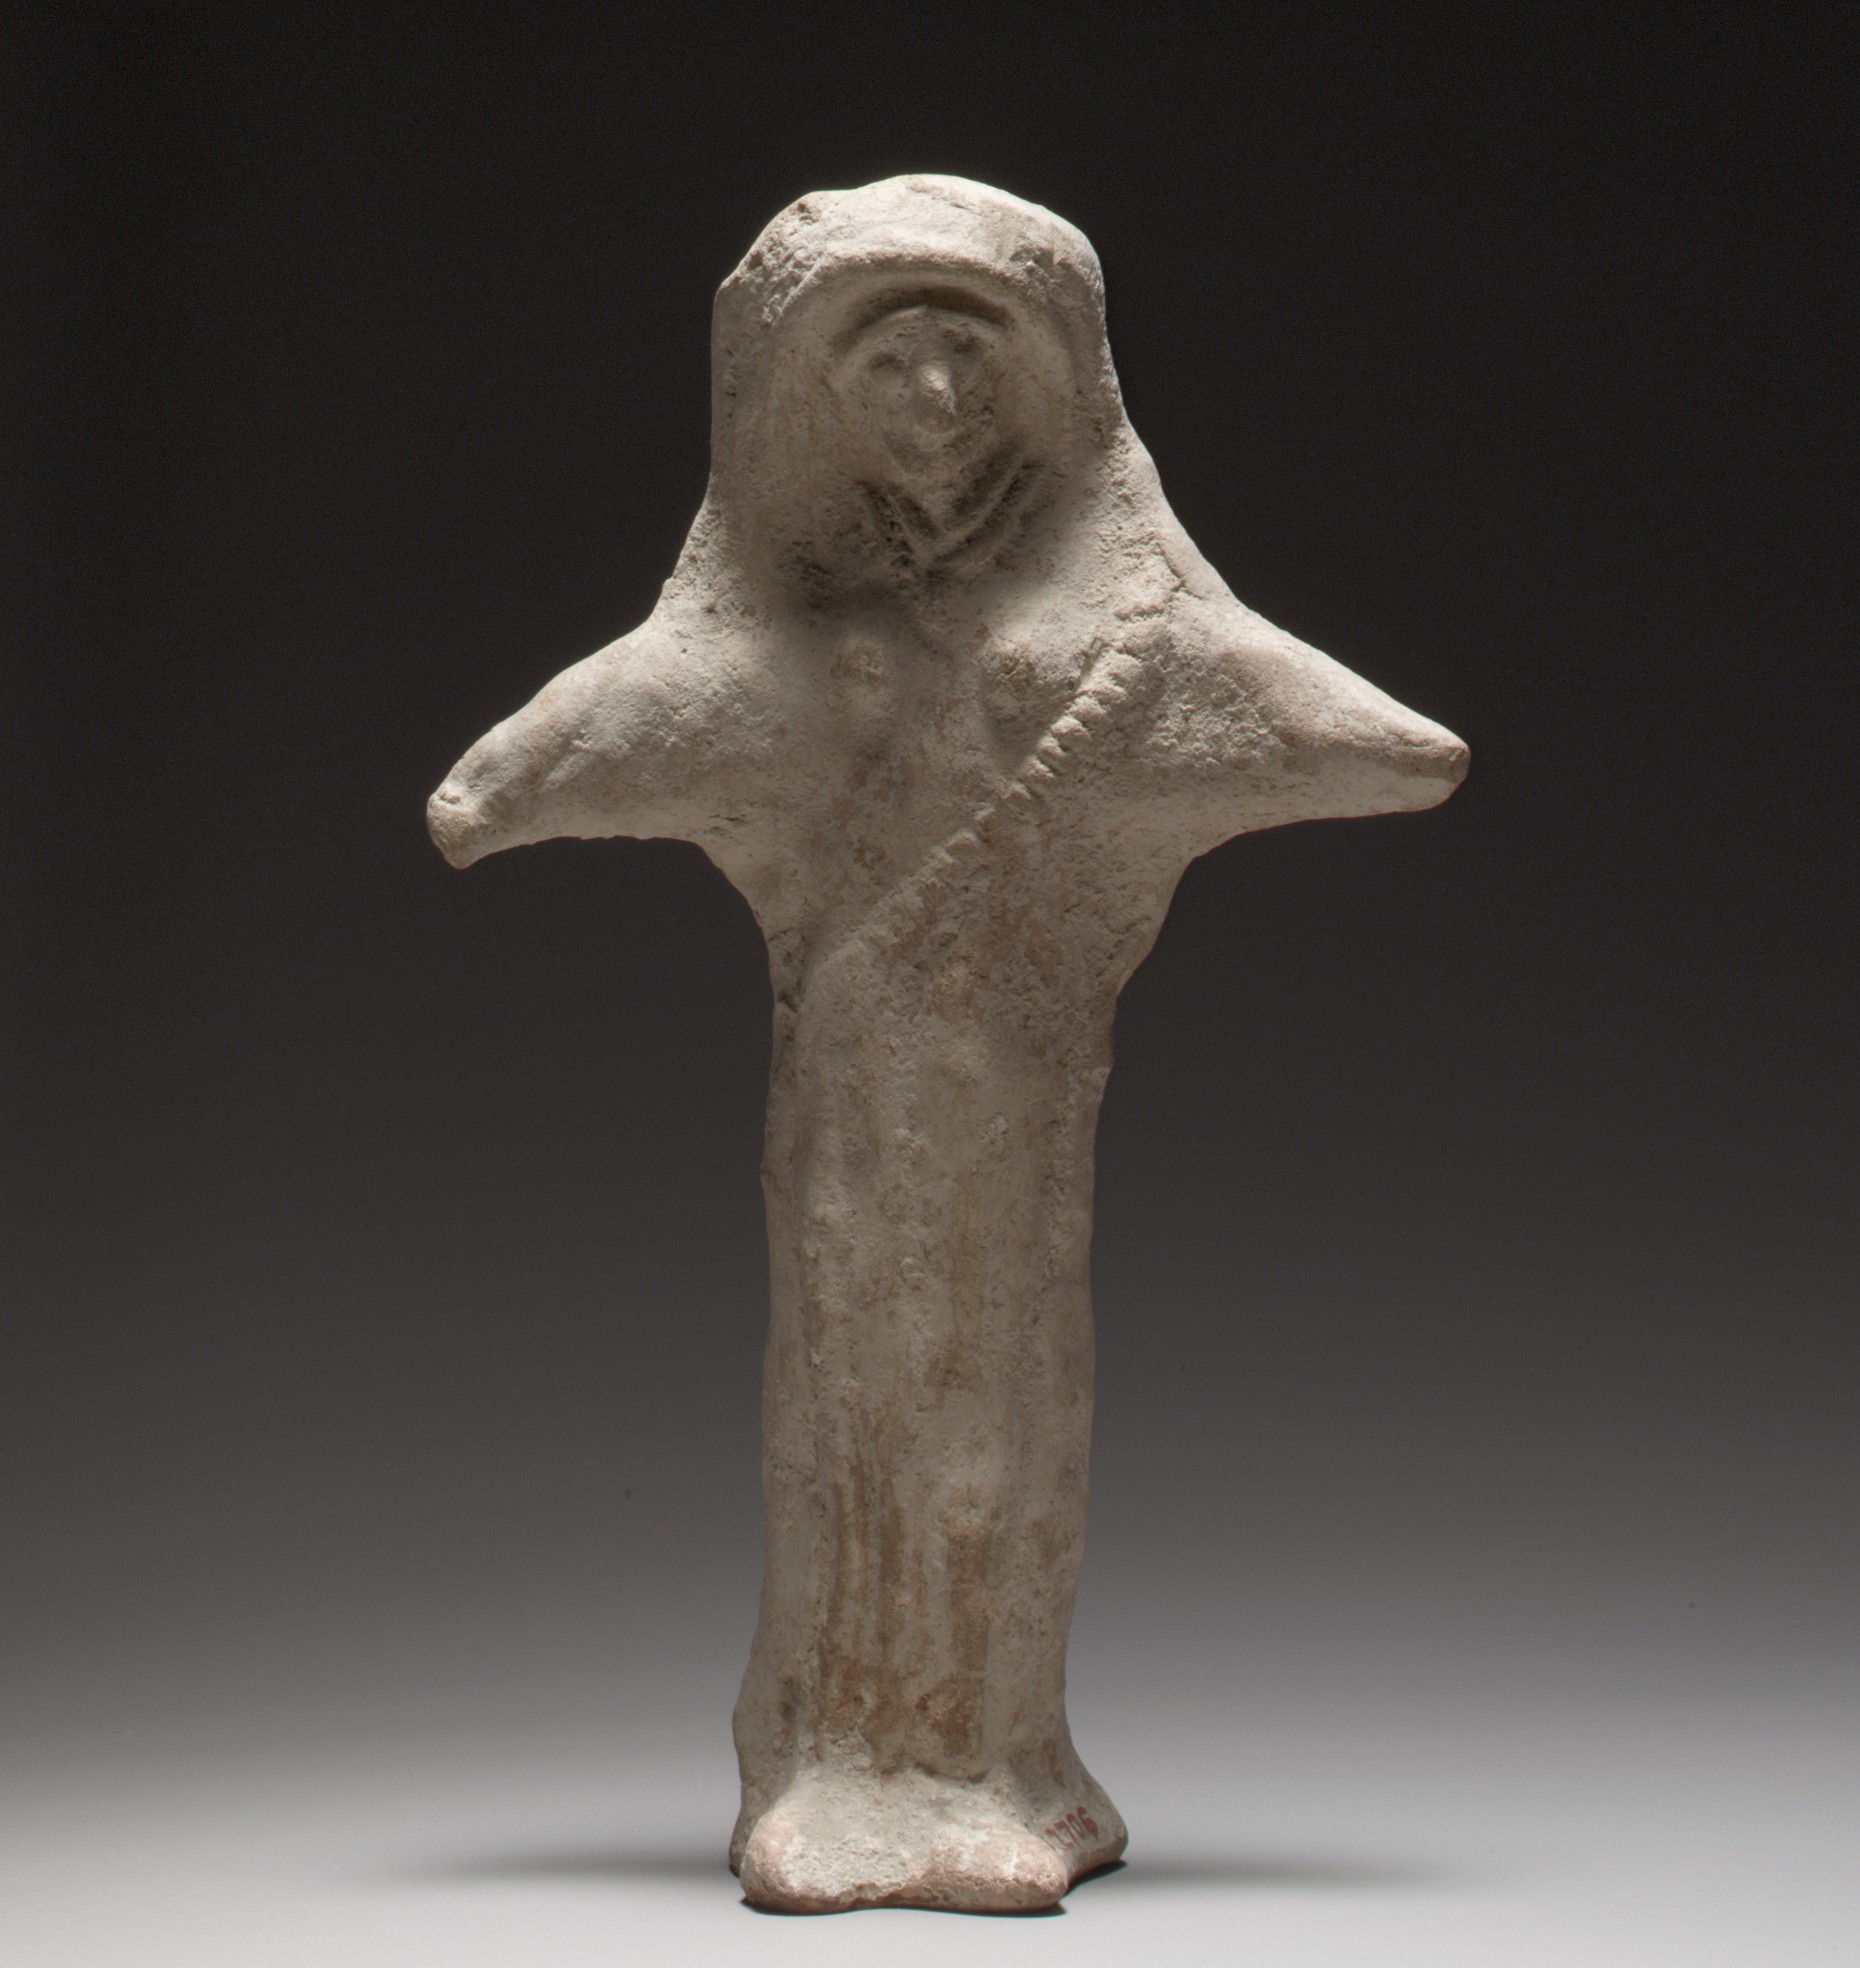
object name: statuette of a female from a ring dance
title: Standing female figurine (cruciform)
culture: cypriot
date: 400-301 BCE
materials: terracotta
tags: women